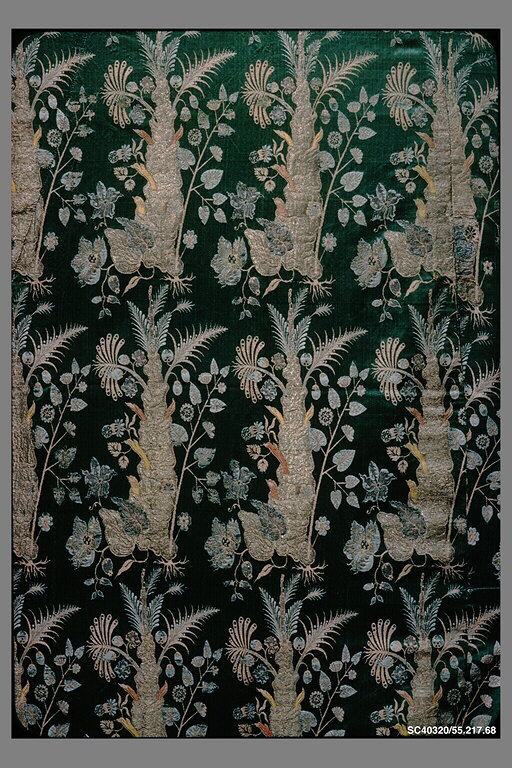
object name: piece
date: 1725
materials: metal thread, silk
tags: flowers,leaves